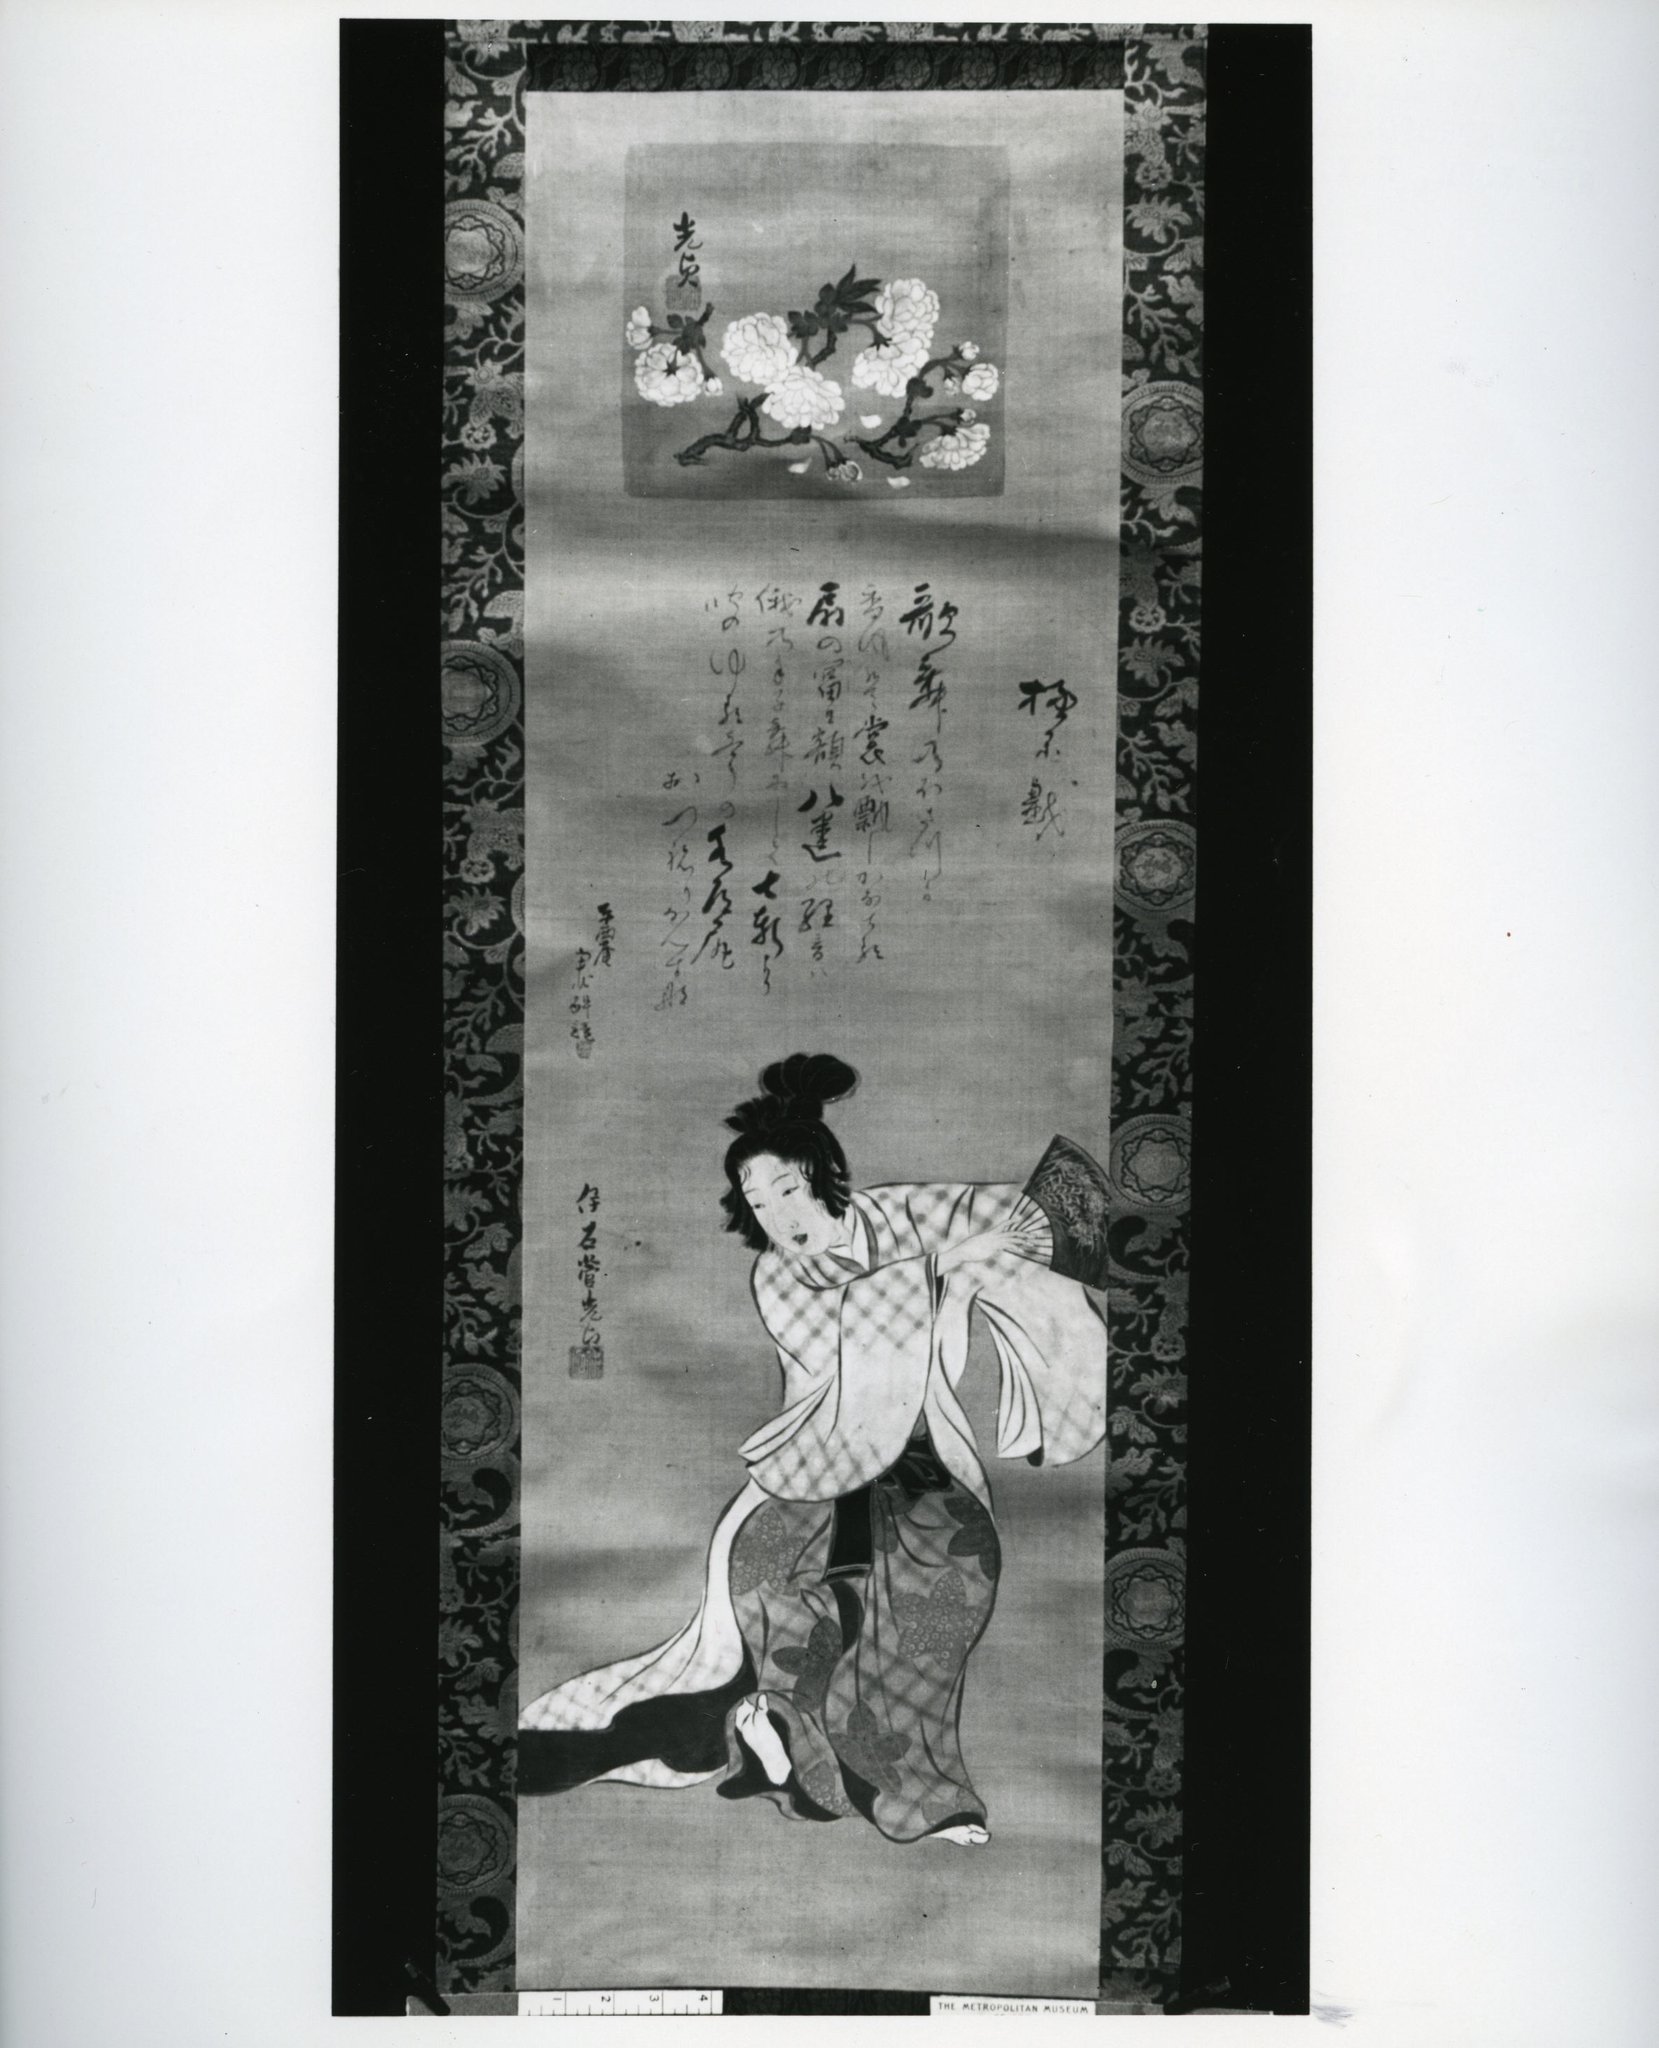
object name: hanging scroll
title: Pleasure Quarters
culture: japanese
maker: suga mitsusada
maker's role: artist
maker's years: 1738-1806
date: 1701-1900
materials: ink, silk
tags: women,flowers